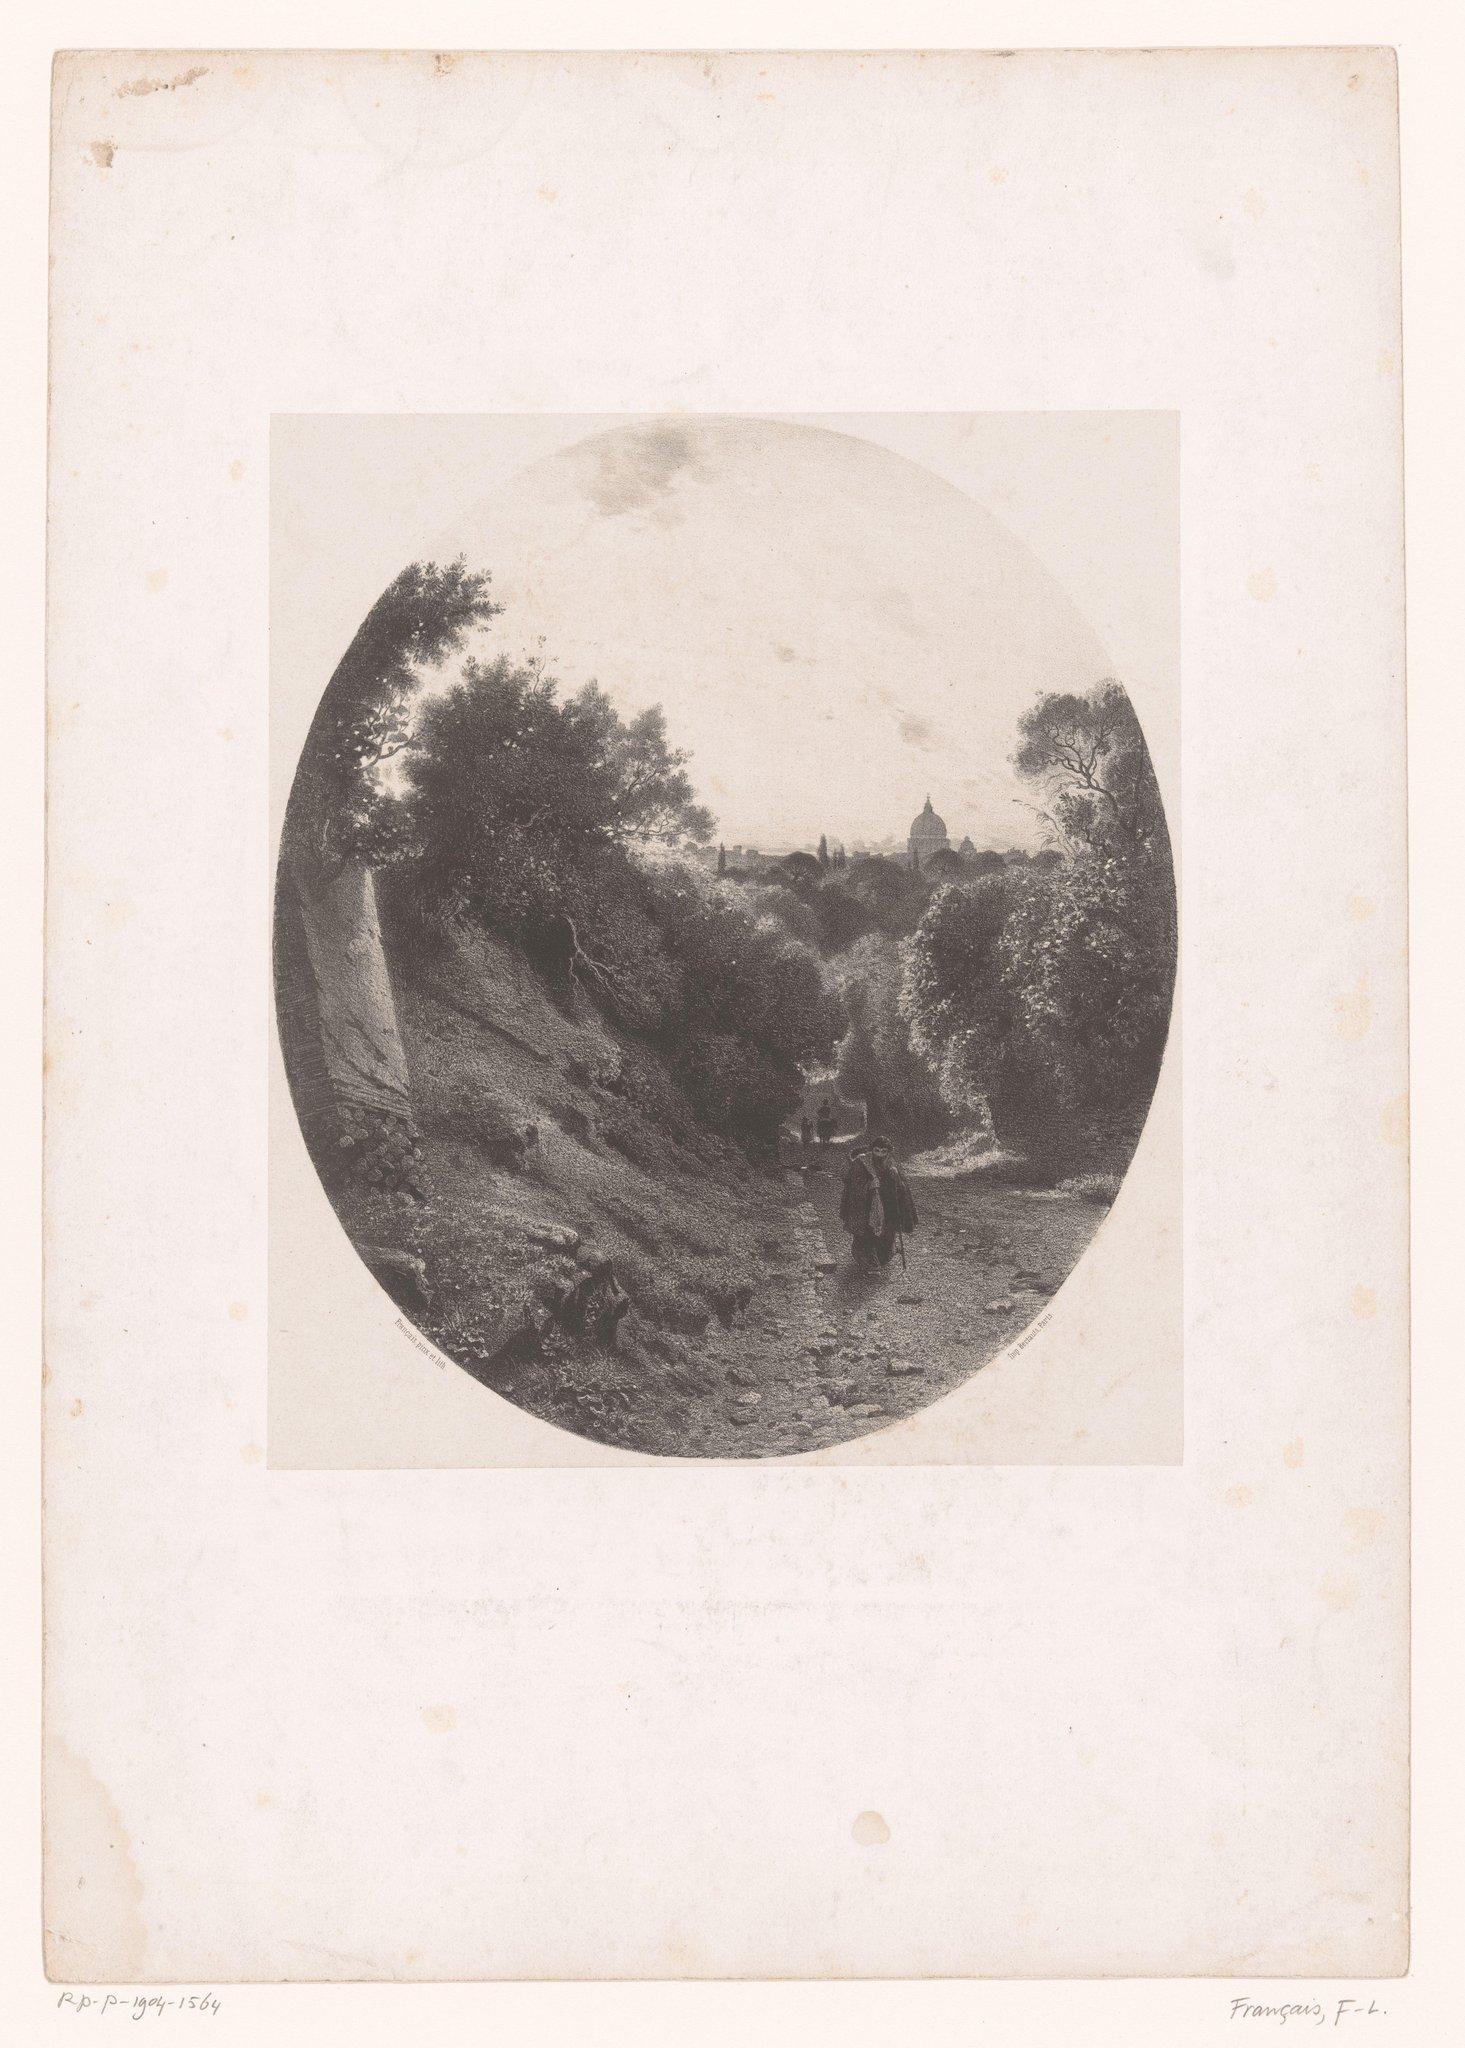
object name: print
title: Stadsgezicht met pad en reizigers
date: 1827-1880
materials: paper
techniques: lithograph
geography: paris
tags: road, path, 'en route', traveller under way, prospect of city, town panorama, silhouette of city (+ city(-scape) with figures, staffage)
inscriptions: collector's mark: Lugt 2228a